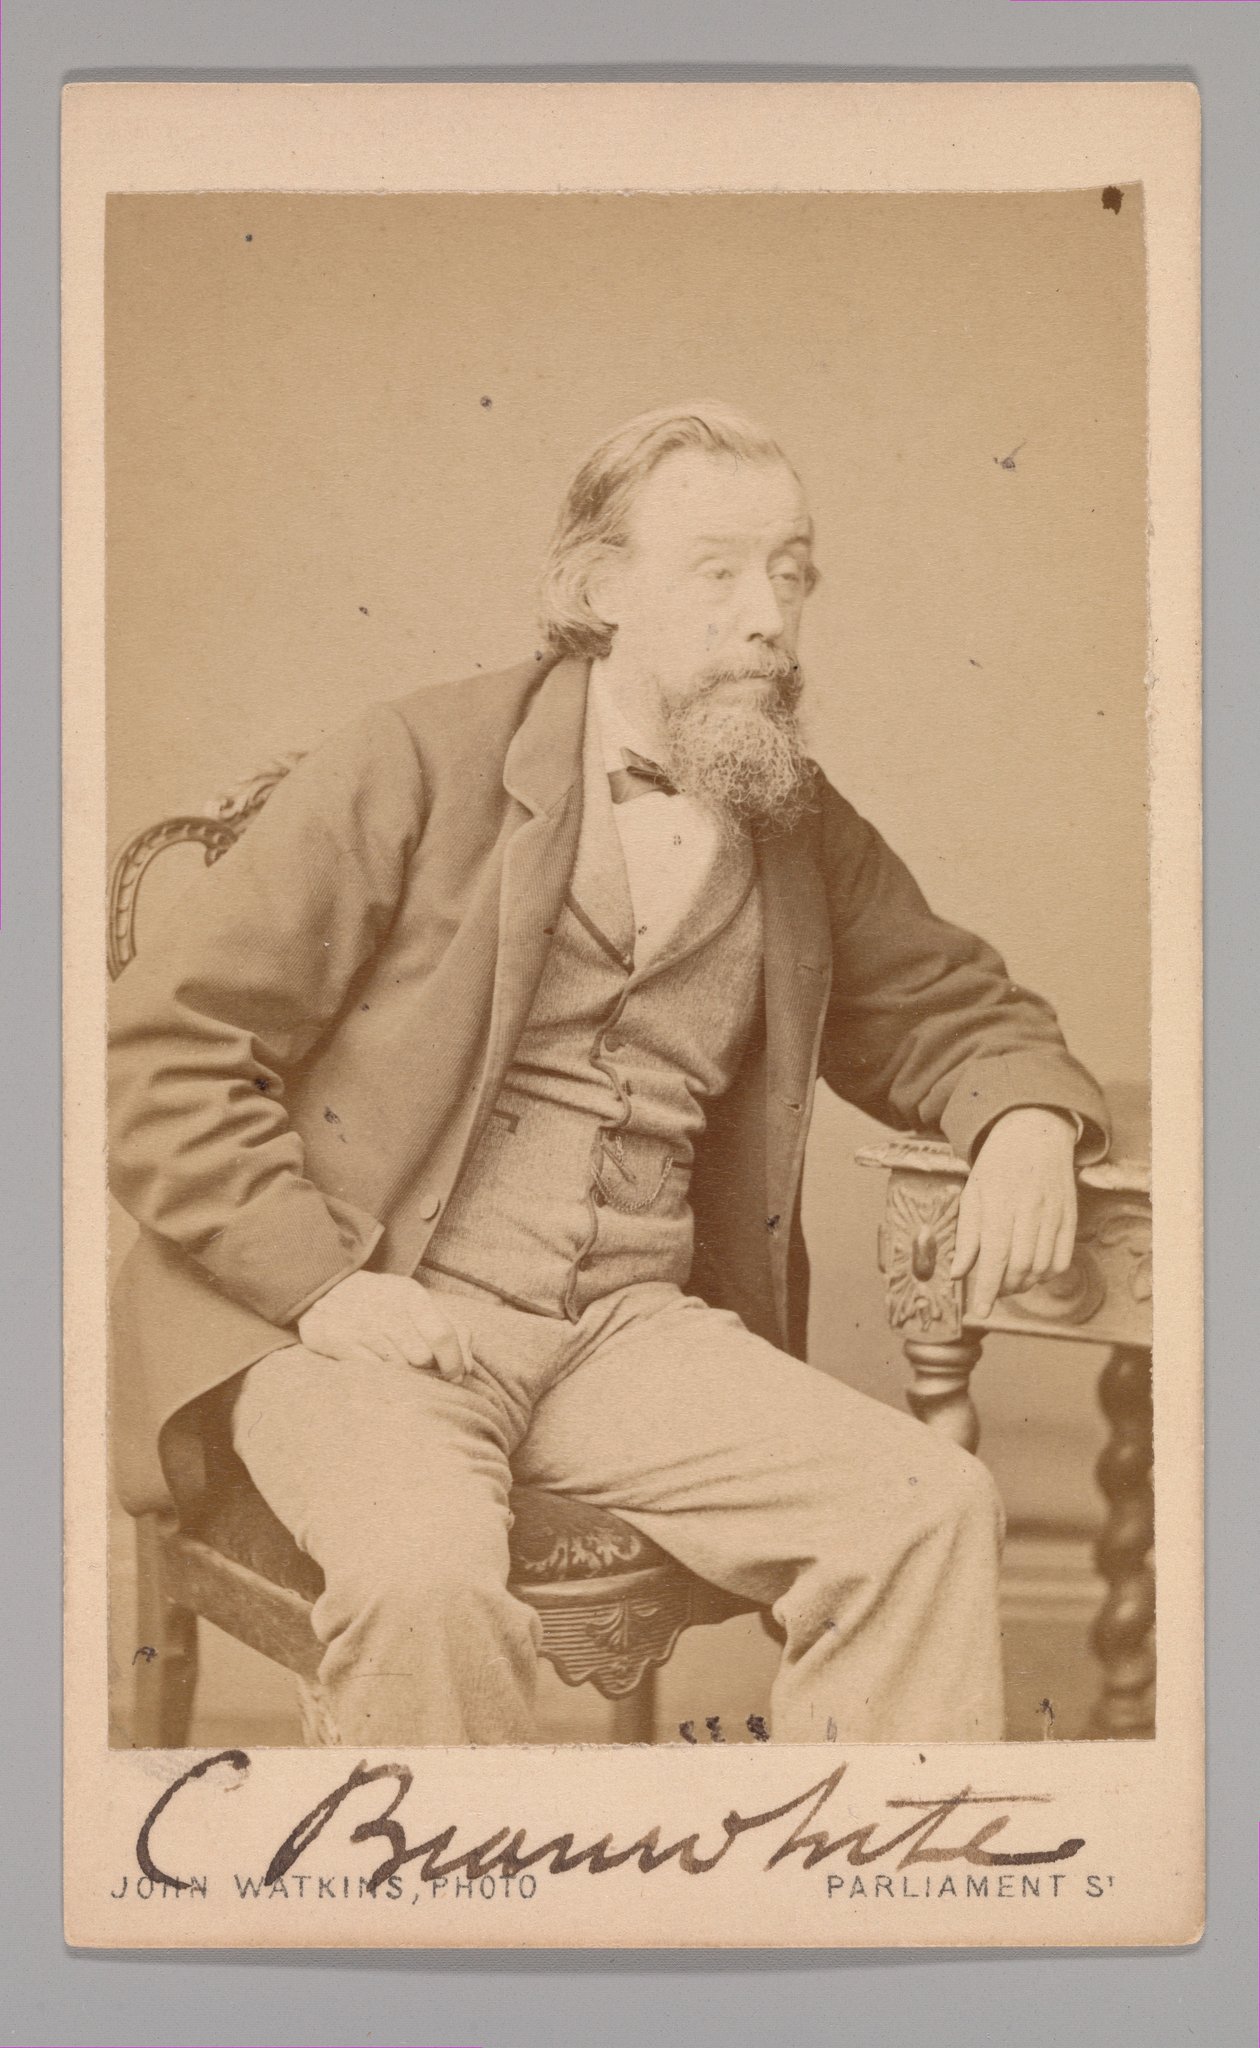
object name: carte de visite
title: [Charles Branwhite]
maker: Anonymous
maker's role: artist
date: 1860-1869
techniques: albumen silver print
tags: men,portraits